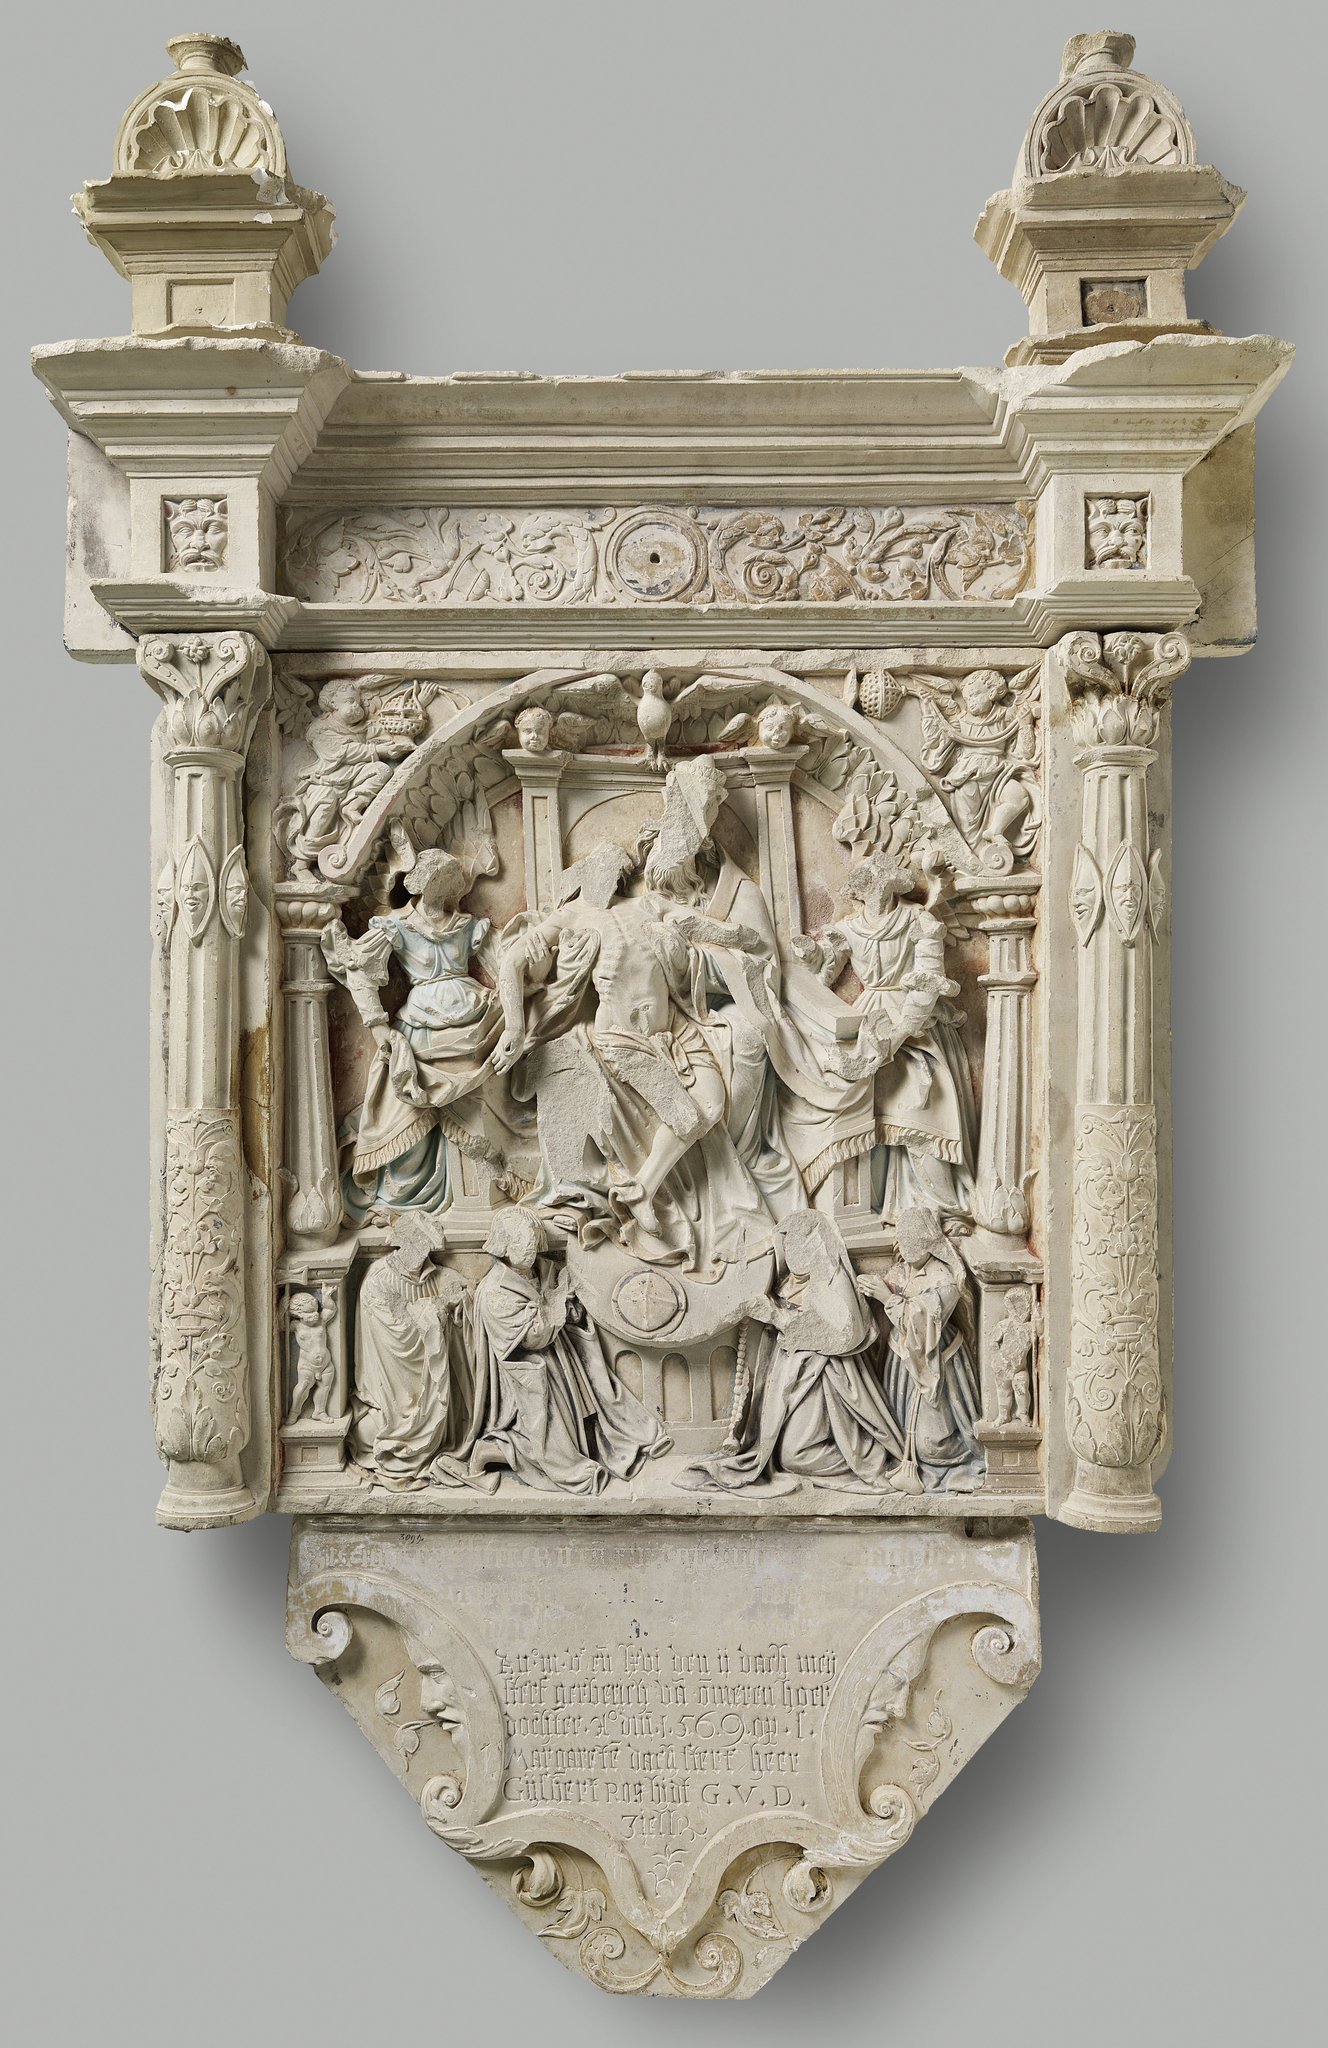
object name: relief sculpture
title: Linkerzuil van epitaaf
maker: arnt van tricht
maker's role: sculptor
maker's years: -1570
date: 1548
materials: stone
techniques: polychromy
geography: kalkar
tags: wageningen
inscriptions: inscription: ‘ANo MVc EN LXVI DEN II DACH MEIJ STERF GERBERICH VA OMEREN HOOR DOCHTER / Ao DOMINI 1569 OP S: MARGARETE DACH STERF HEER GIJSBERT ROS Bidt G.V.D. ZIELL’, inscription: ‘INT IAER ONS HERE MVcXLVIII OP SINTE EGIDII DACH STERF DERRICK ROS / Ao DNI VC o STERF NERTWICH SIJN HUYSFROU o SIEL’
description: Onderdeel van epitaaf van de familie Ros uit de Grote Kerk te Wageningen.